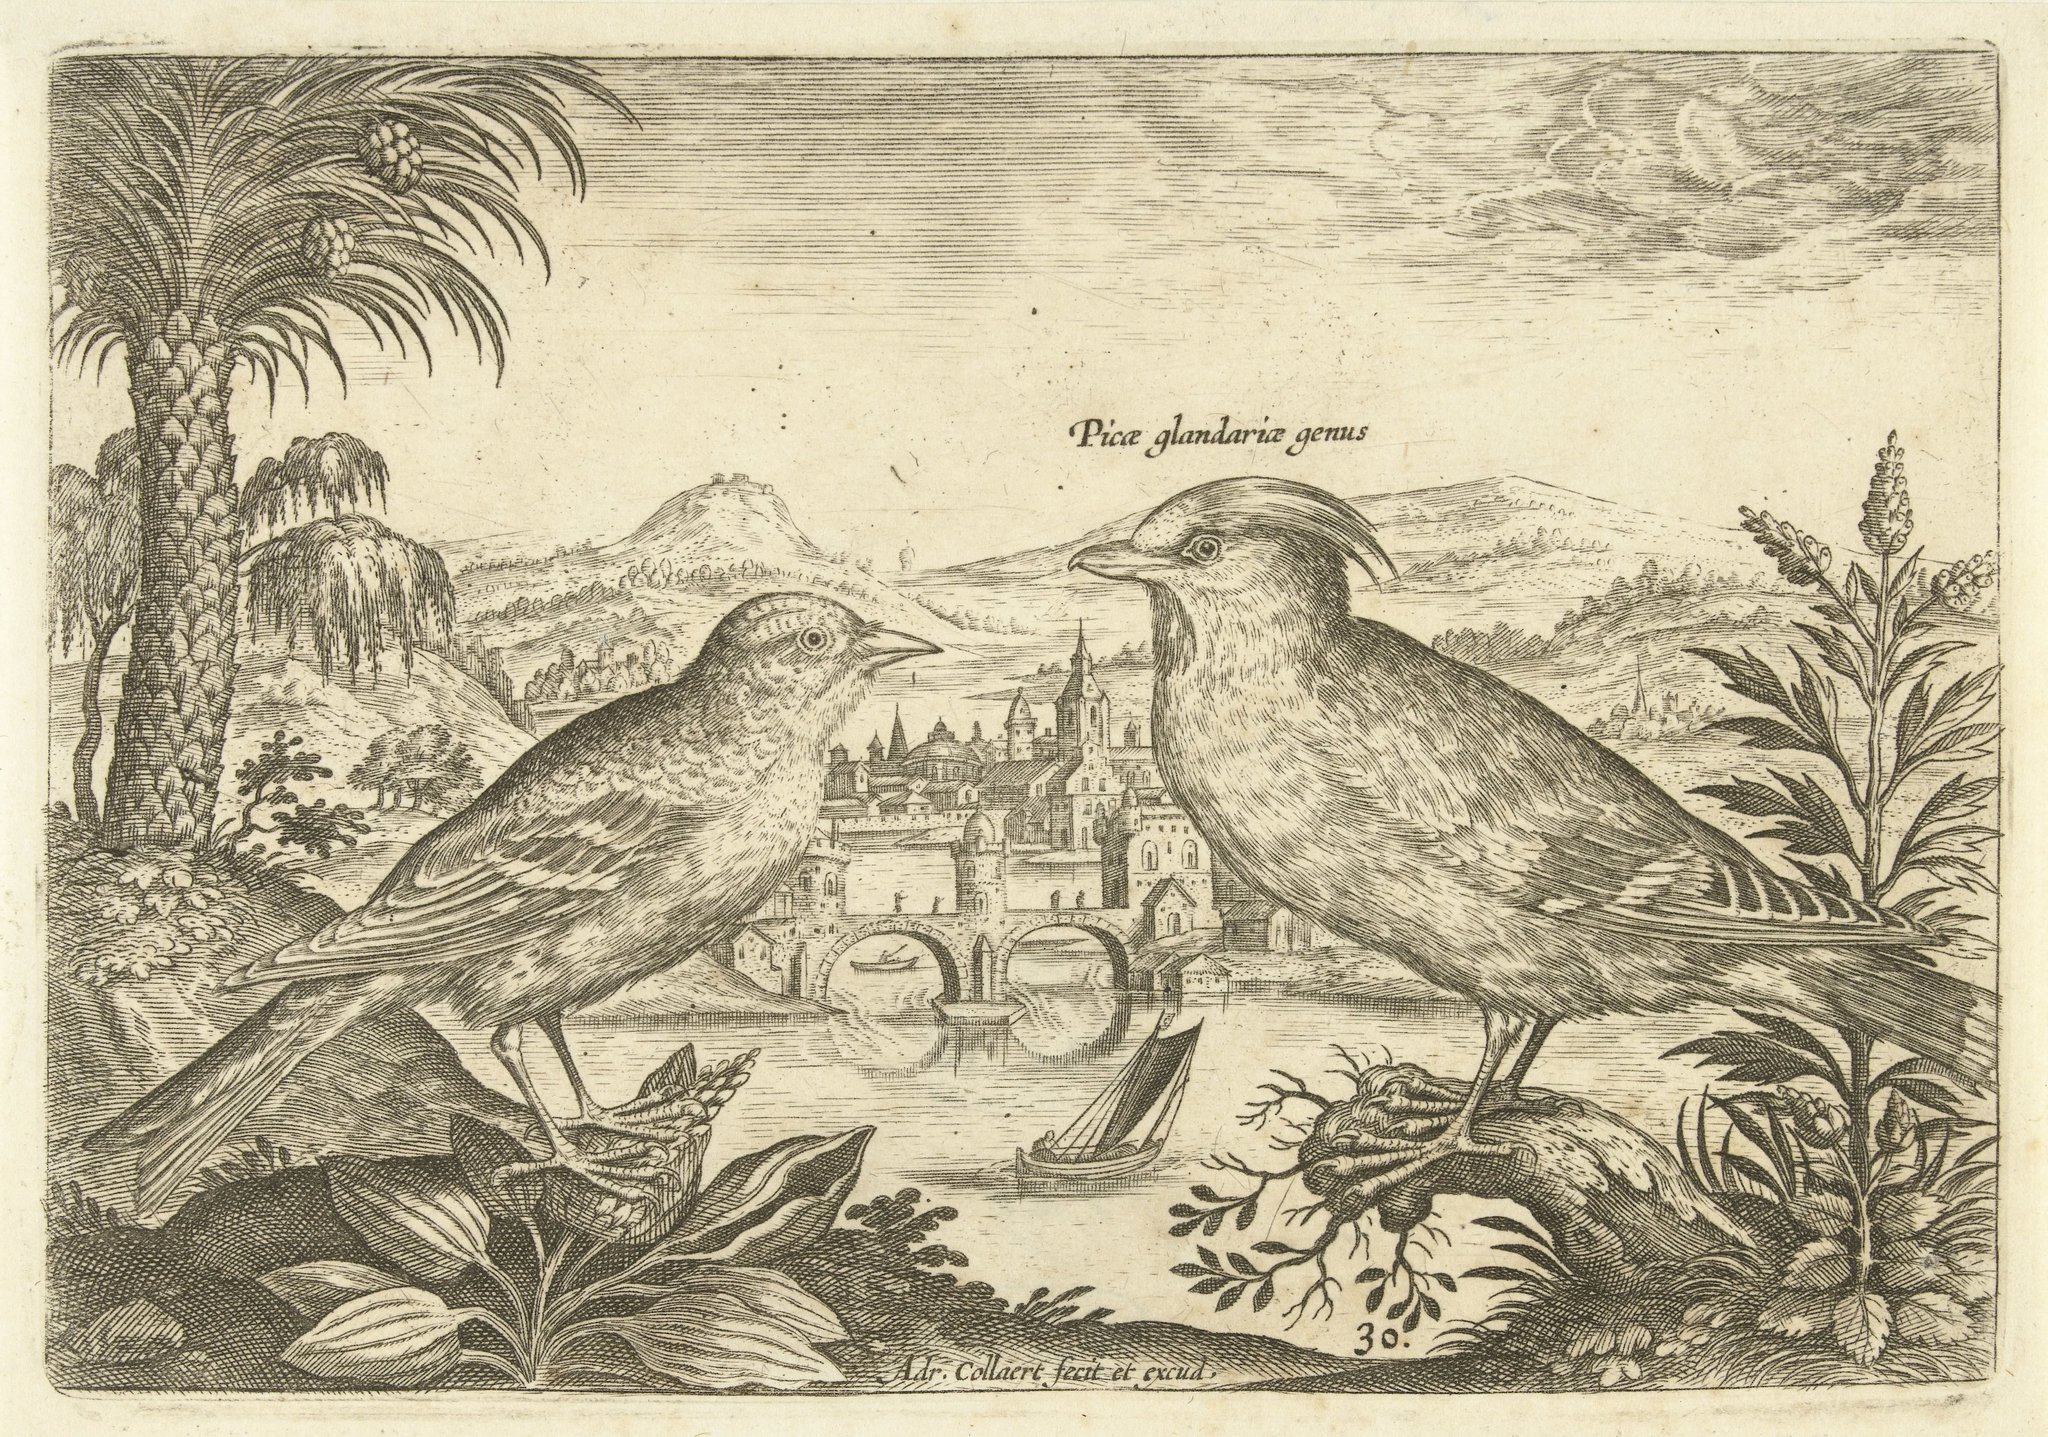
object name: print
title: Twee vogels in een landschap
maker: adriaen collaert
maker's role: draughtsman, print maker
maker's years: 1560-1618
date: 1598-1602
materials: paper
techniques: engraving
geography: antwerp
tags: song-birds, landscape with bridge, viaduct or aqueduct (+ city(-scape) with figures, staffage), song-birds: waxwing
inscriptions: collector's mark: Lugt 2228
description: Een pestvogel en een andere vogel op de voorgrond. Op de achtergrond een brug over een rivier. De prent maakt deel uit van een serie met vogels als onderwerp.